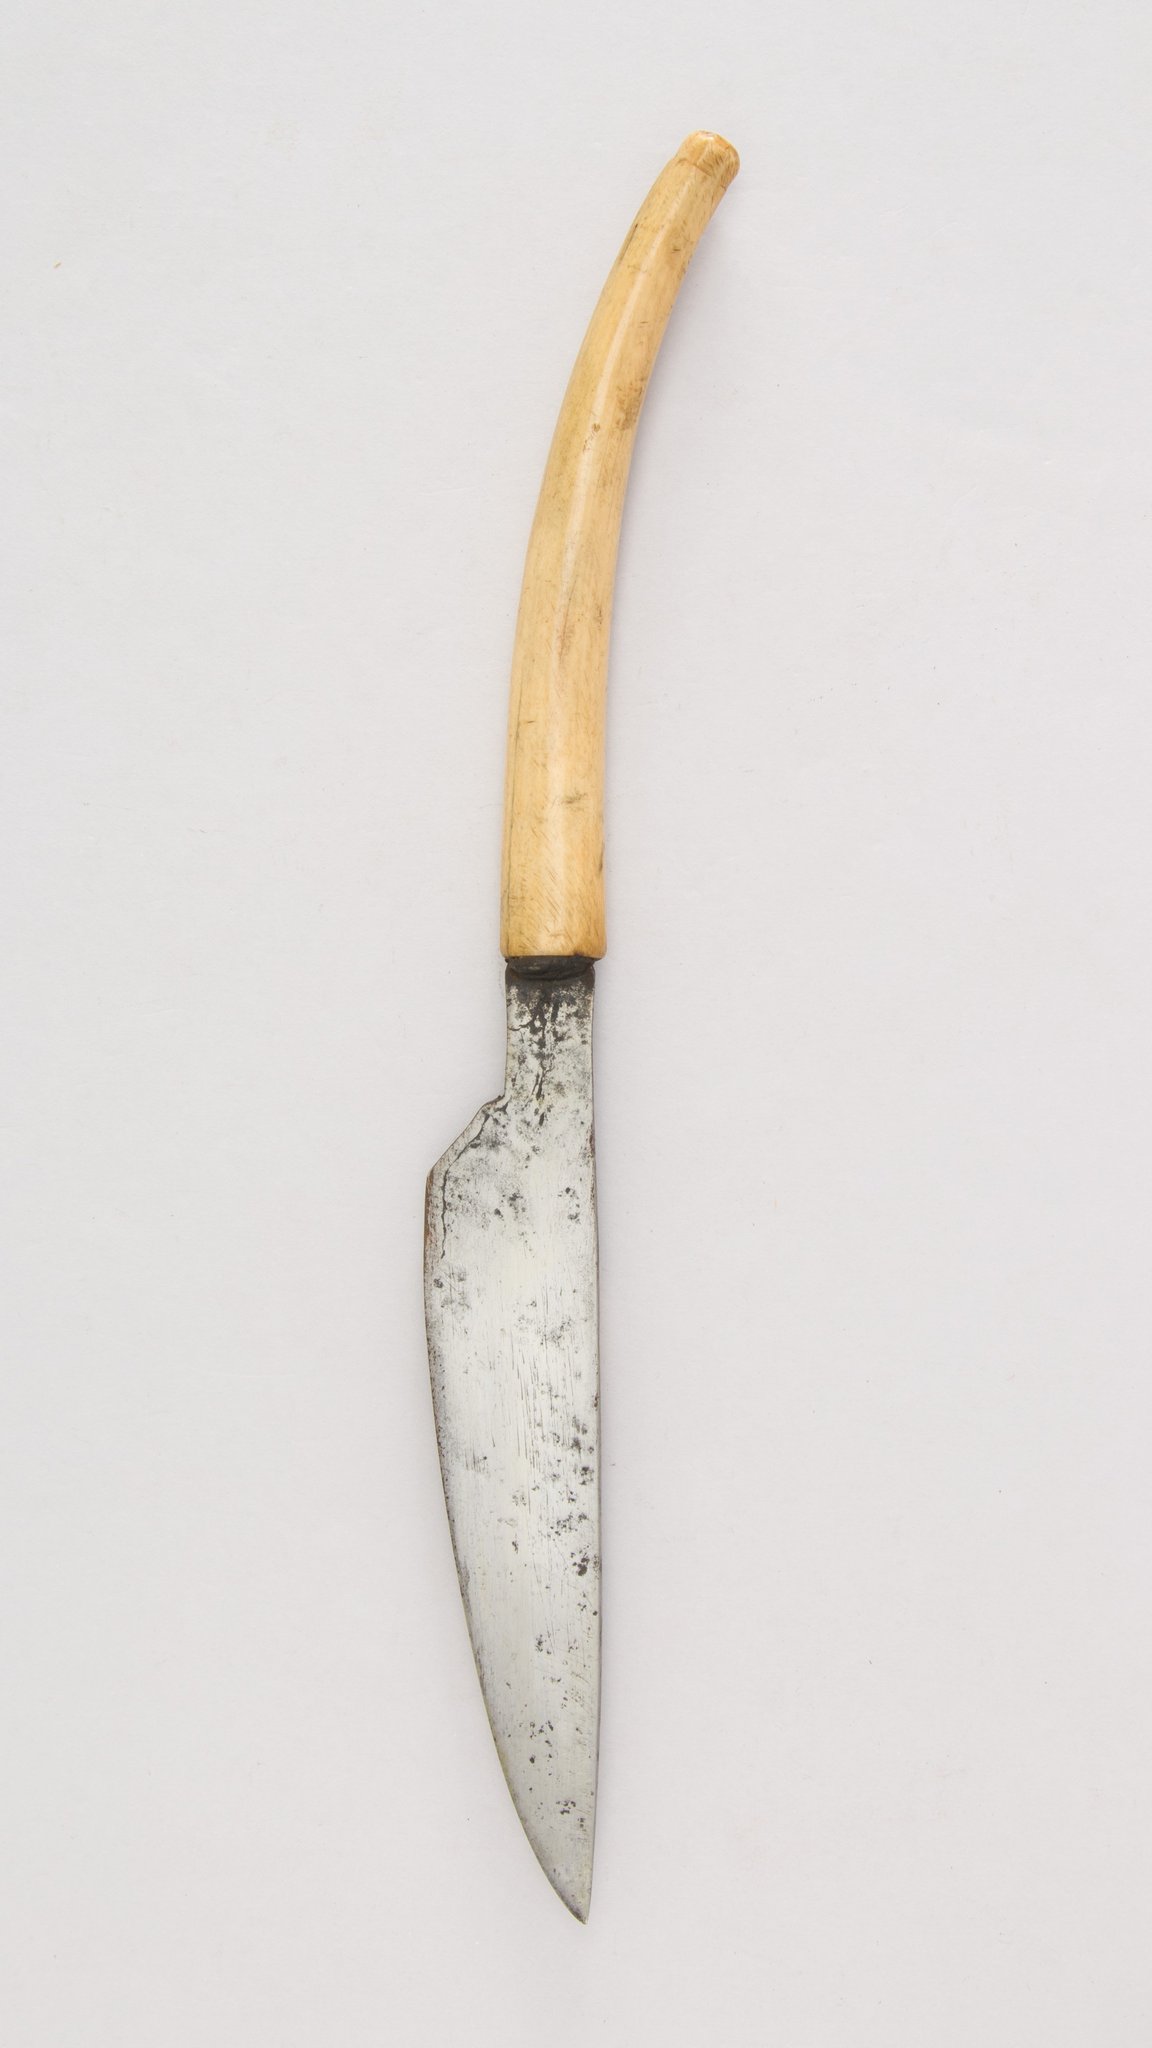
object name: knife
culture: philippine, sulu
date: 1701-1900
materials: bone, steel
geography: philippines